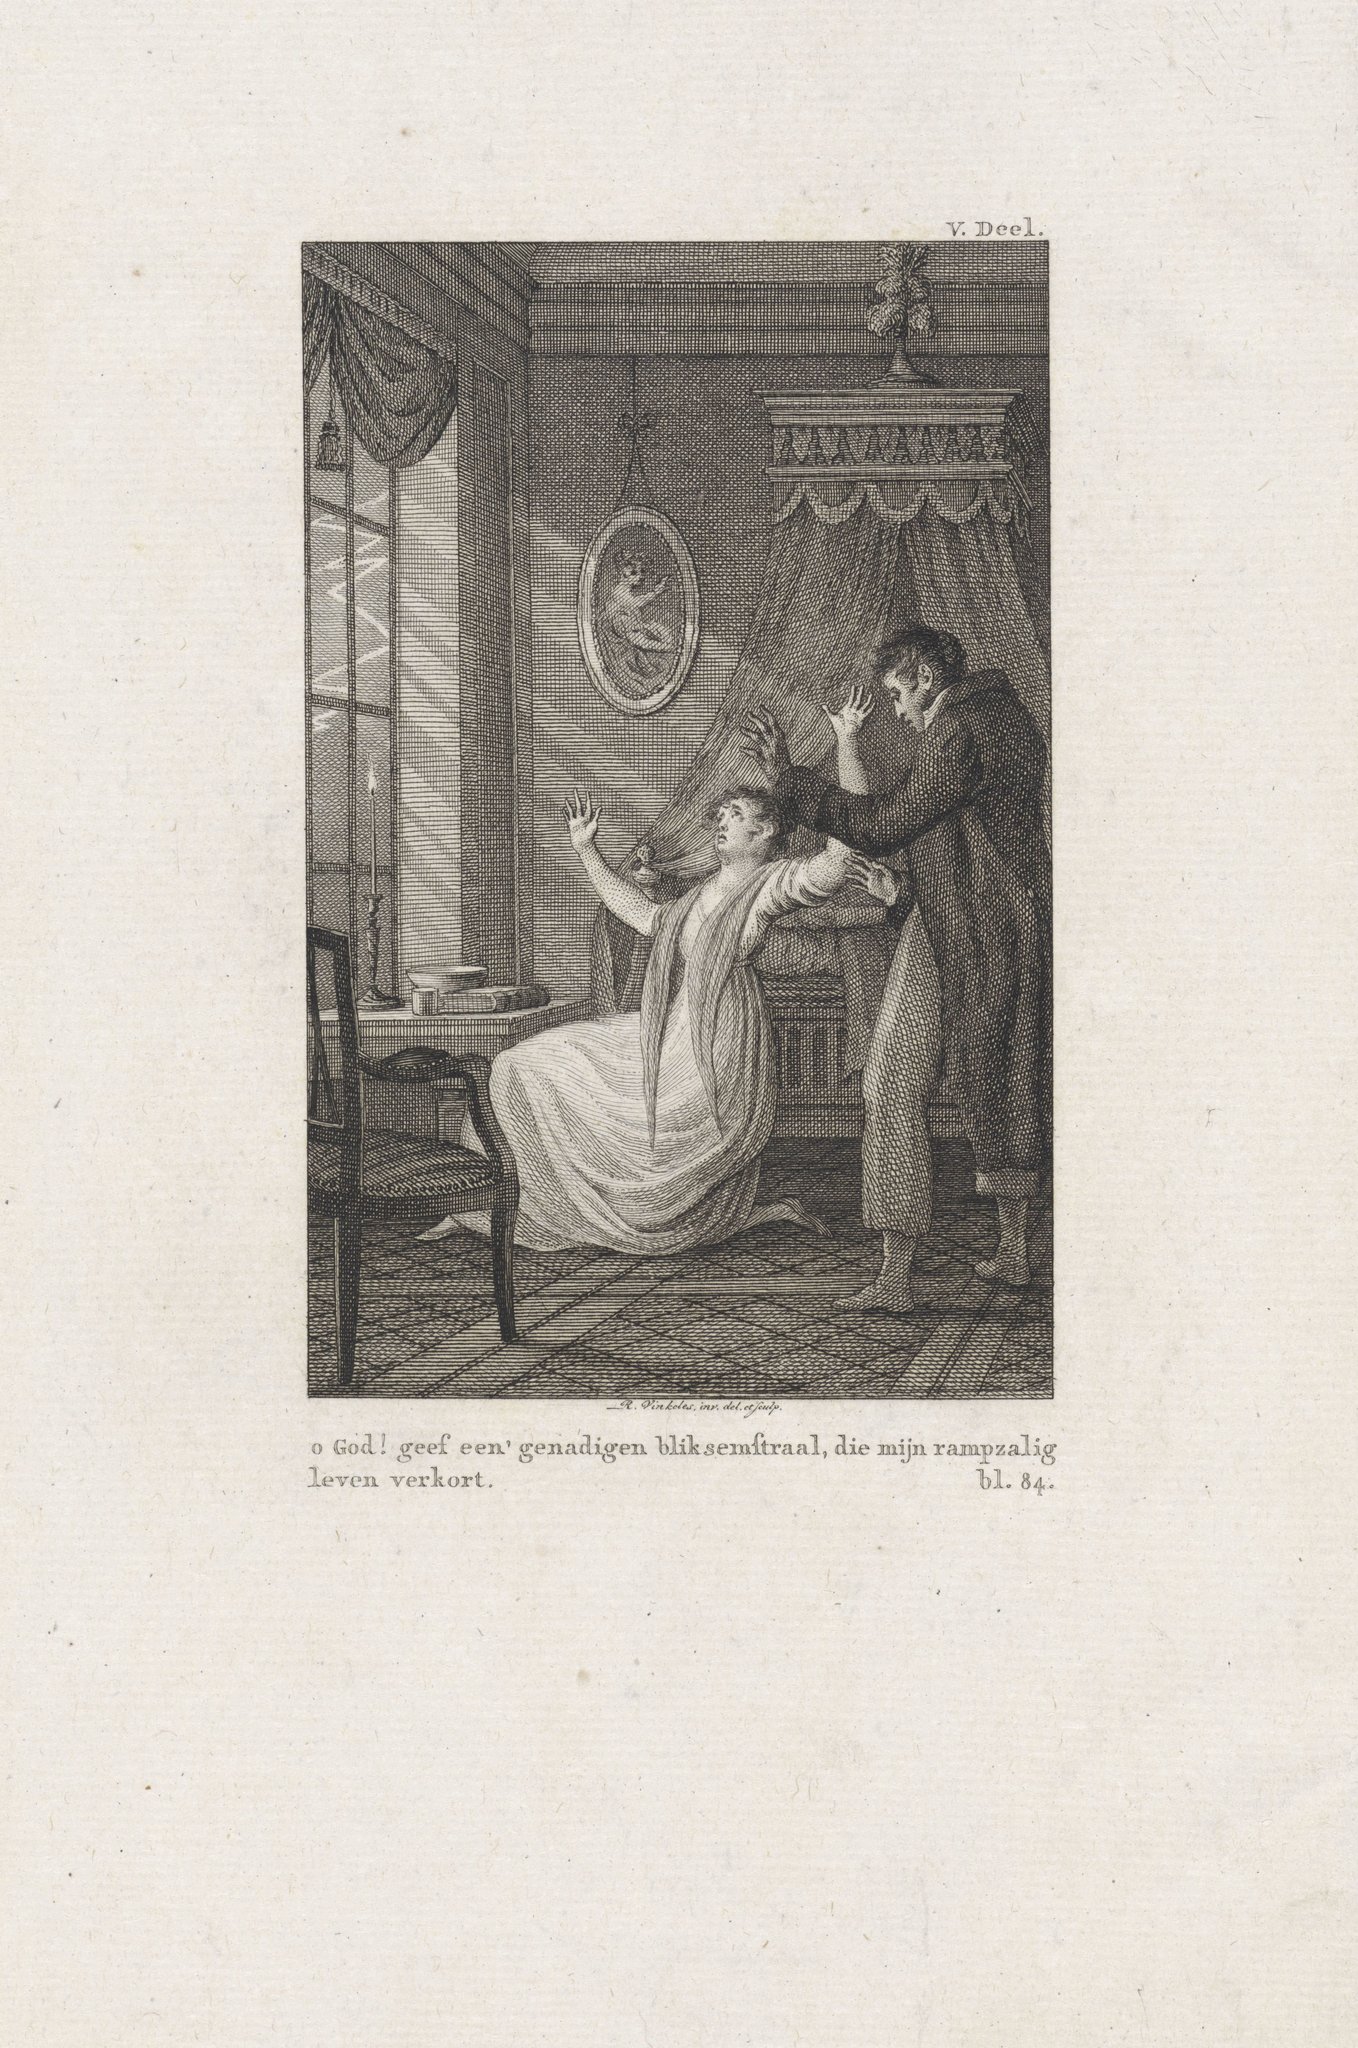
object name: print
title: Paar schrikt van een bliksemschicht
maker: reinier vinkeles (i)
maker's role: draughtsman, print maker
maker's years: 1741-1816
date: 1751-1816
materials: paper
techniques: engraving, etching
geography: amsterdam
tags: candle, bed, lightning, flash of lightning, thunderbolt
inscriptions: collector's mark: Lugt 2228, inscription: ‘O God! geef een genadigen bliksemstraal, die mijn rampzalig / leven verkort. , bl. 84’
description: In een slaapkamer schrikt een paar van een bliksemschicht, bij nacht.